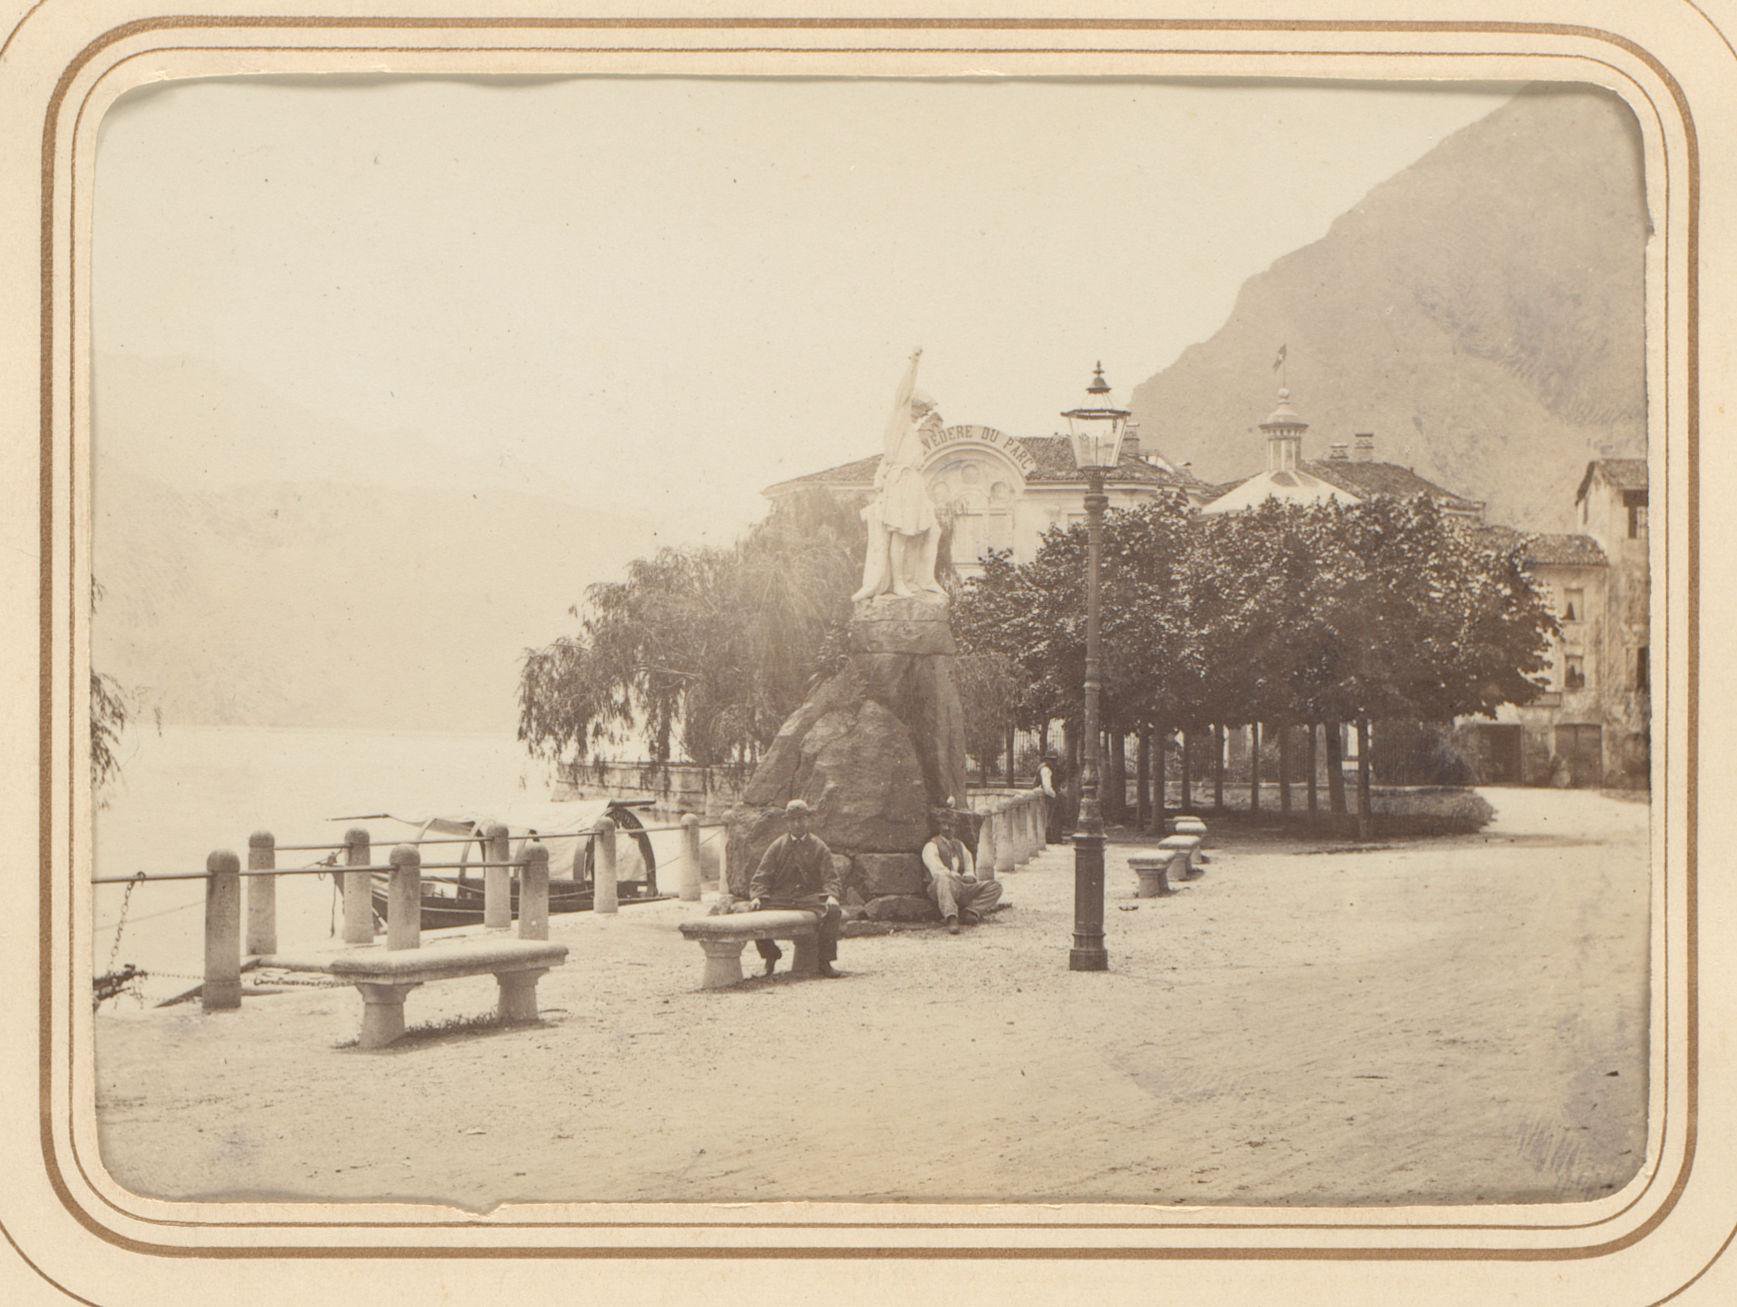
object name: album leaf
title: Standbeeld van William Tell, Lugano, Zwitserland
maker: antonio nessi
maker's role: fotograaf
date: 1865-1885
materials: cardboard, photographic support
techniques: albumen print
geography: lugano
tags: monument, statue, street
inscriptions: name: ‘NESSI A.’, annotation: ‘Monumento a Guiglielmo Tell in Lugano’